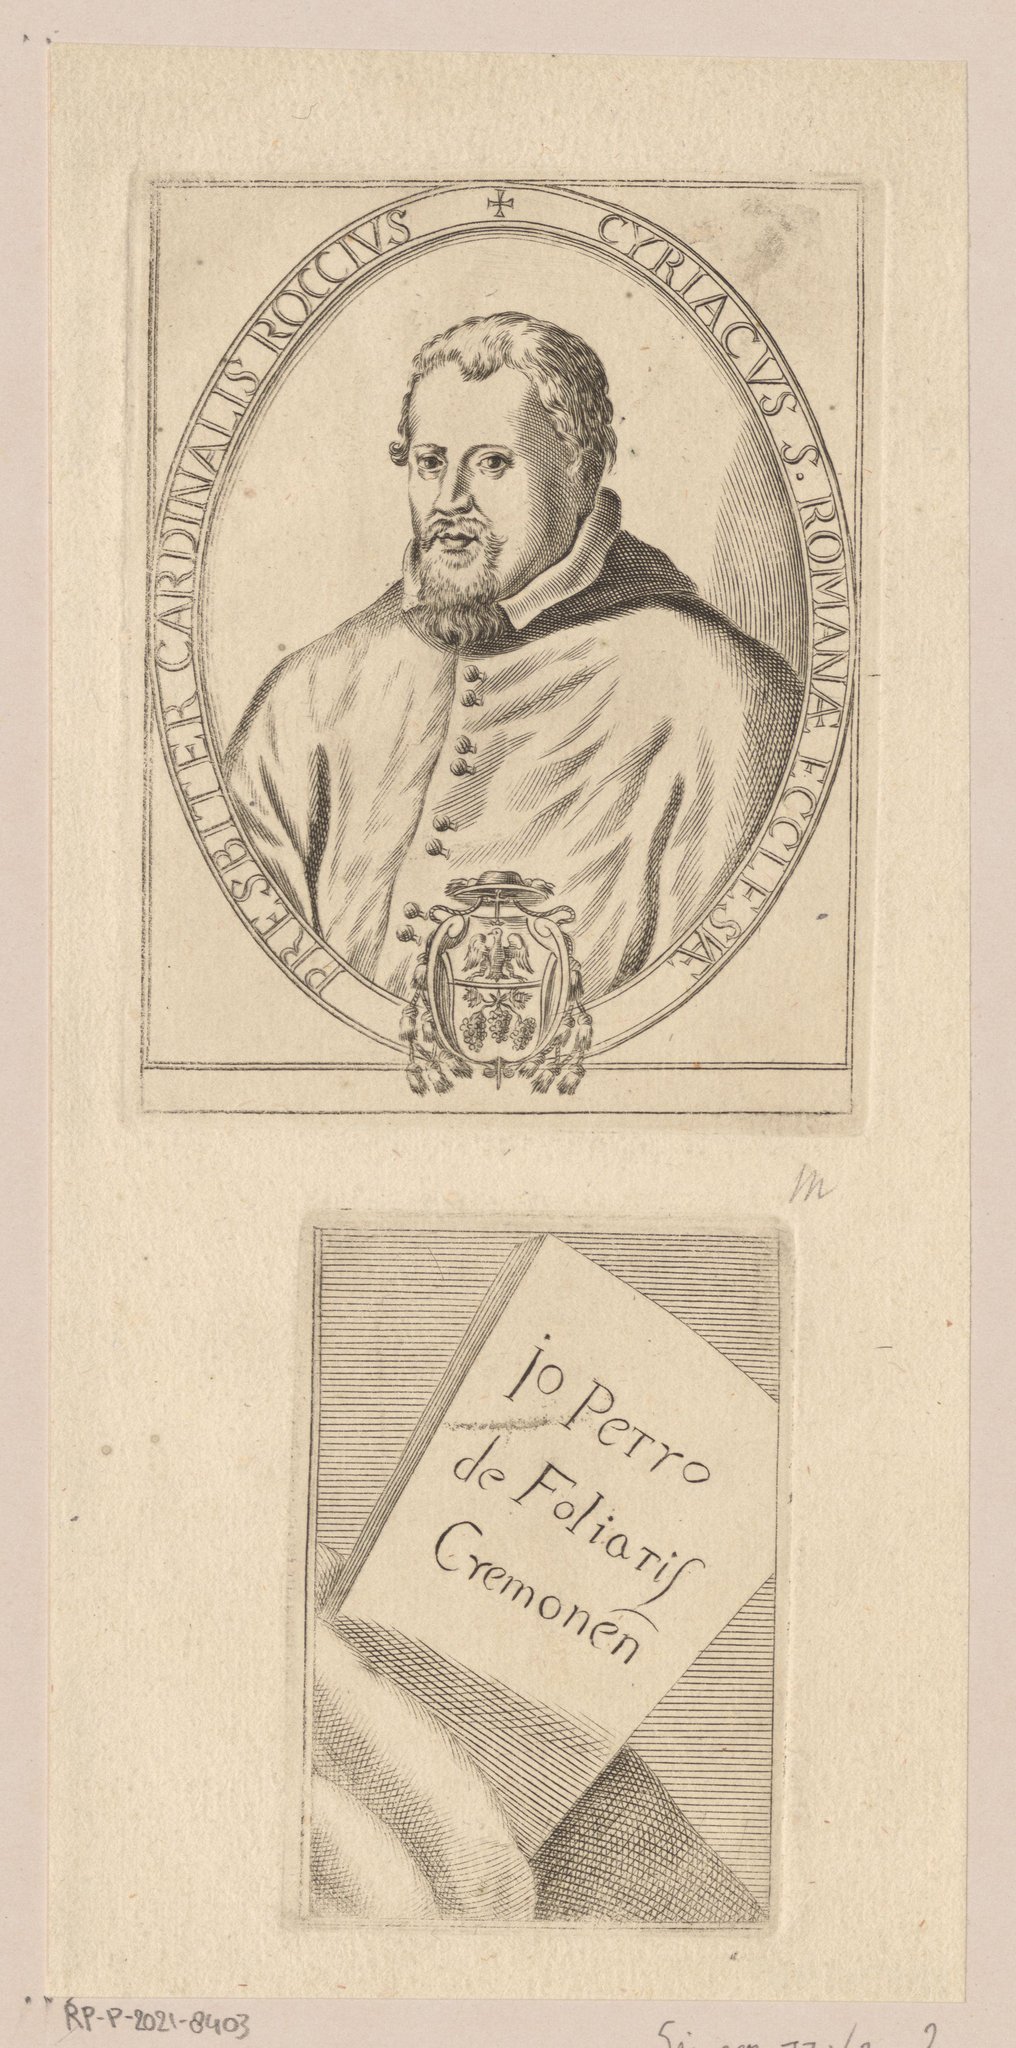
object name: print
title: Portret van Ciriaco Rocci en een hand die een papier vasthoudt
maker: Anonymous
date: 1629-1699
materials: paper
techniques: engraving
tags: historical persons, armorial bearing, heraldry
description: Op het papier de tekst: Io Petro de Foliaris Cremonen. Onder het portret zijn wapenschild.